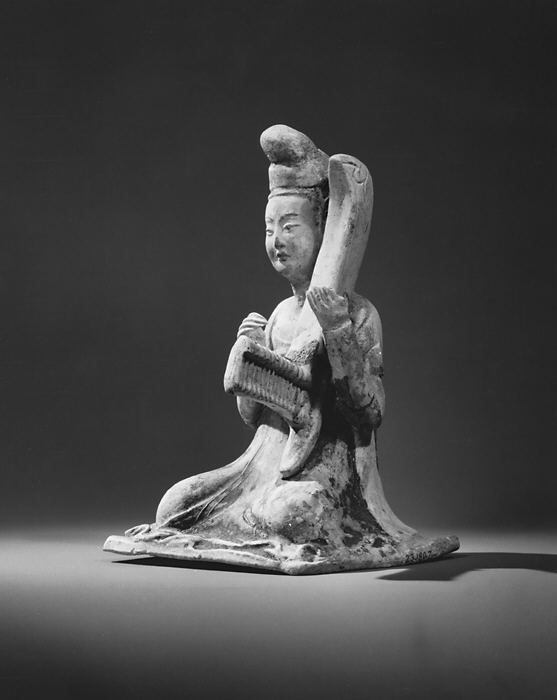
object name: figure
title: Female musician with harp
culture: chinese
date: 667-700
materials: earthenware, pigment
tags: musical instruments,women,musicians